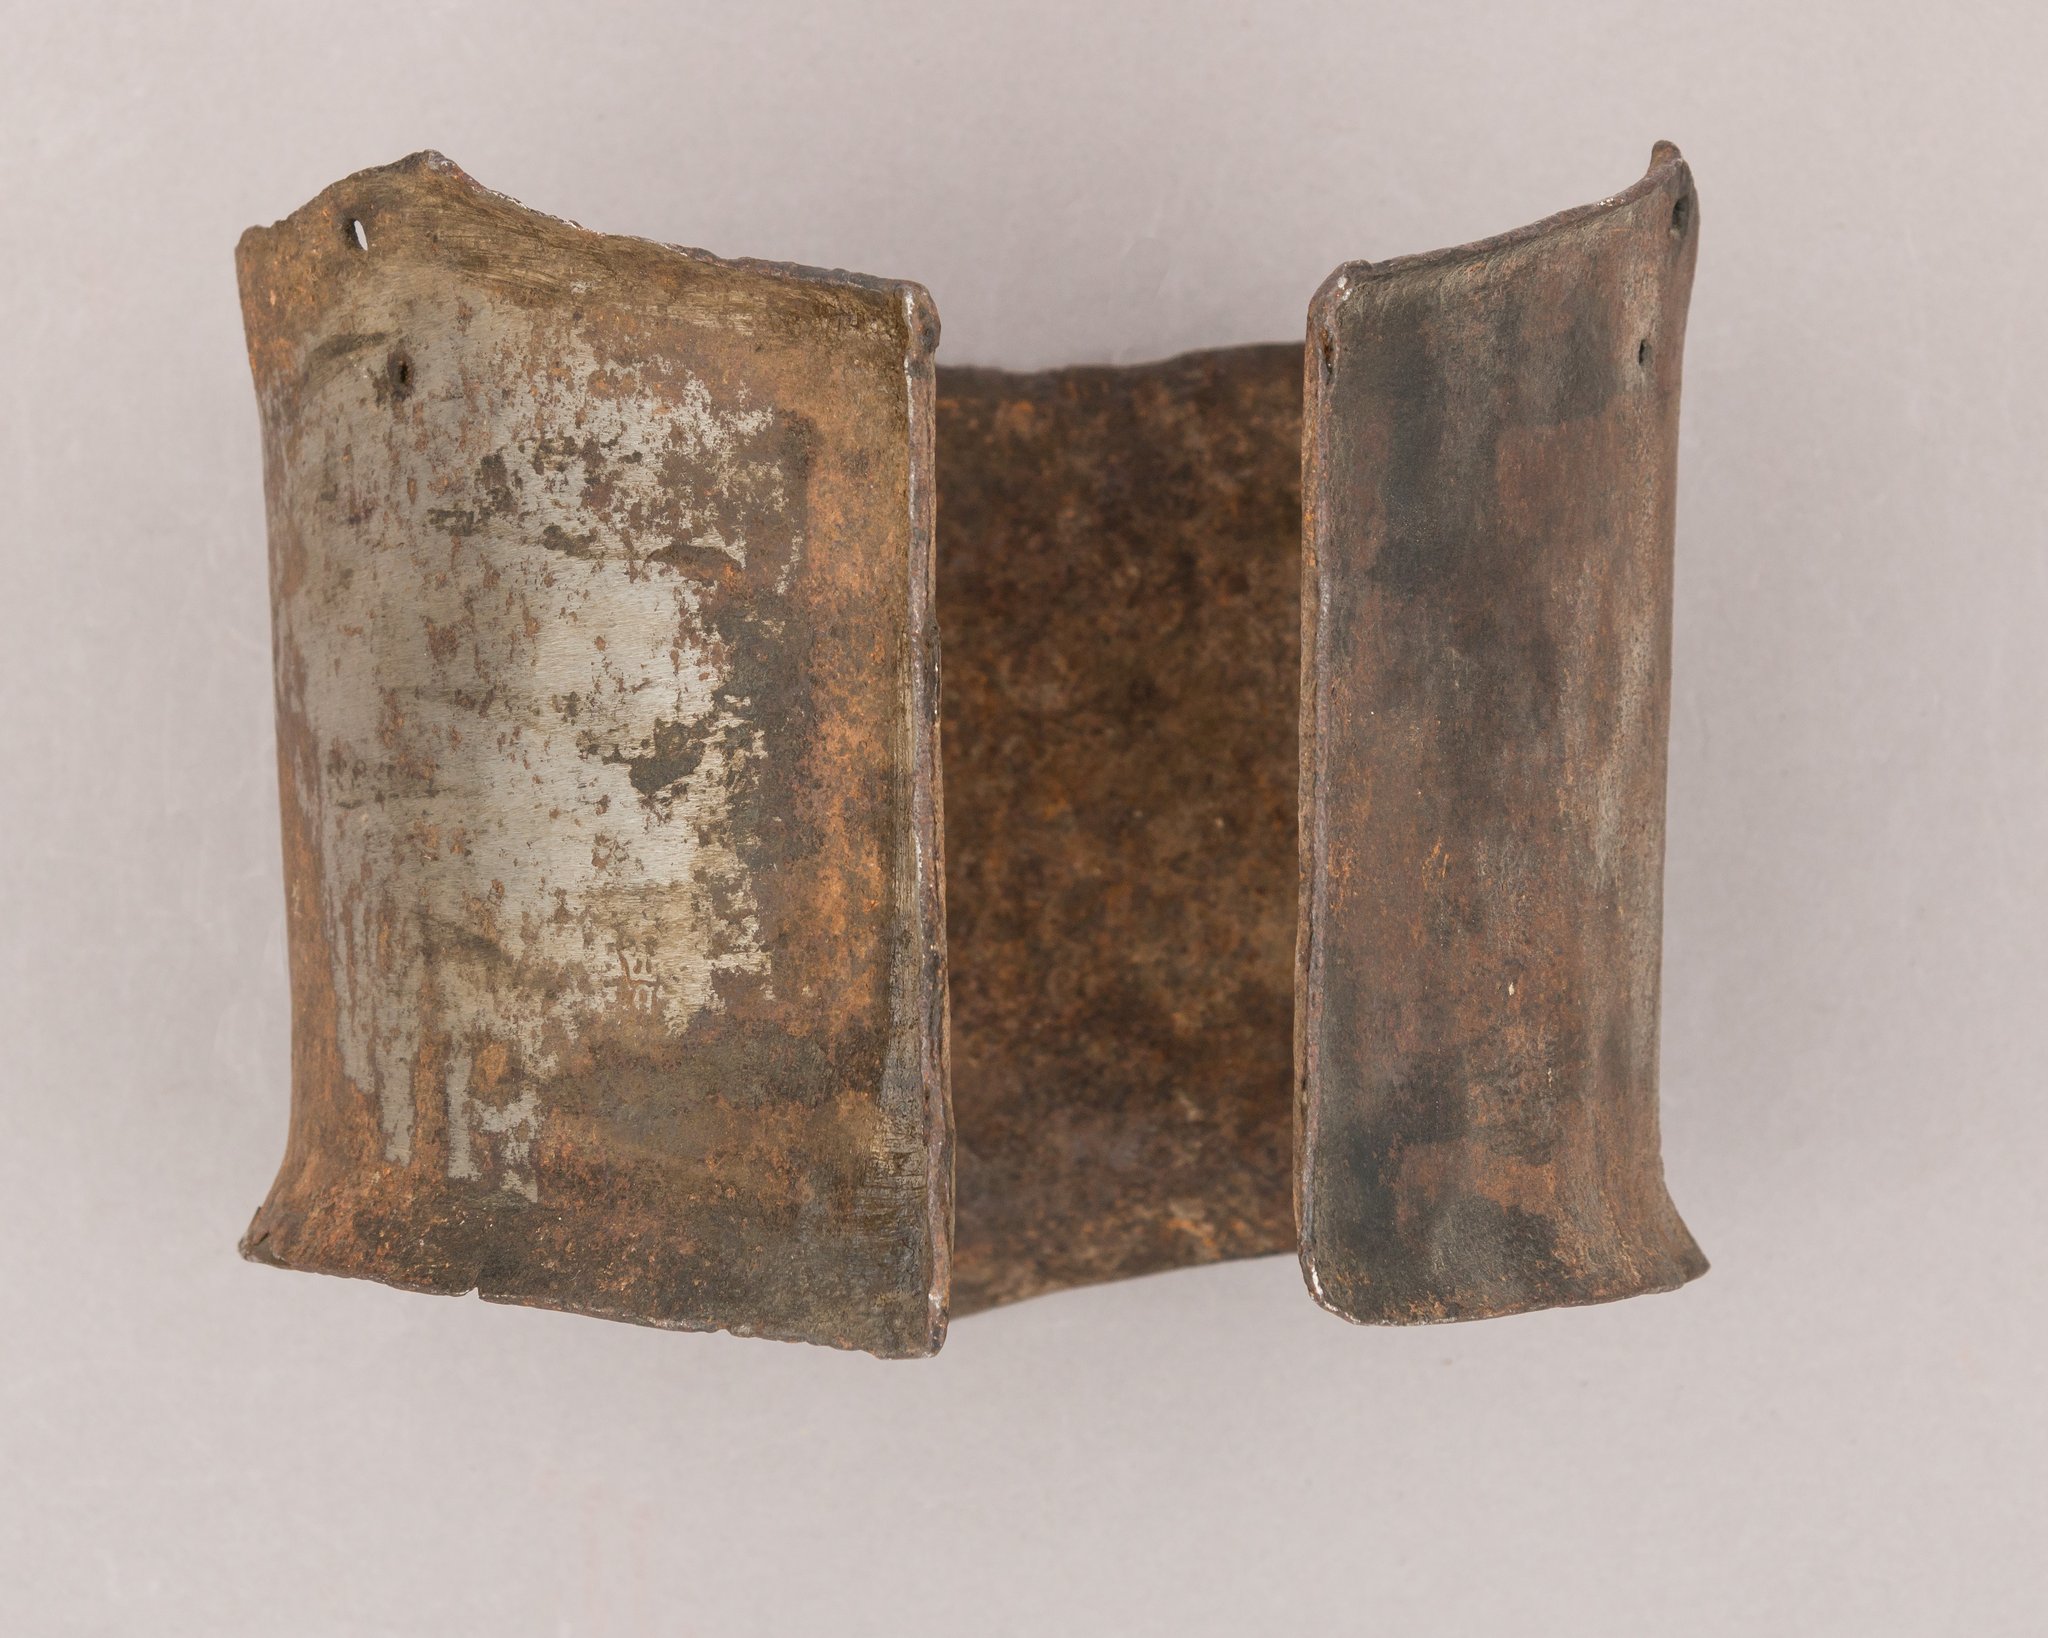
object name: lower plate of a bascinet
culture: italian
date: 1401-1433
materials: iron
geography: italy